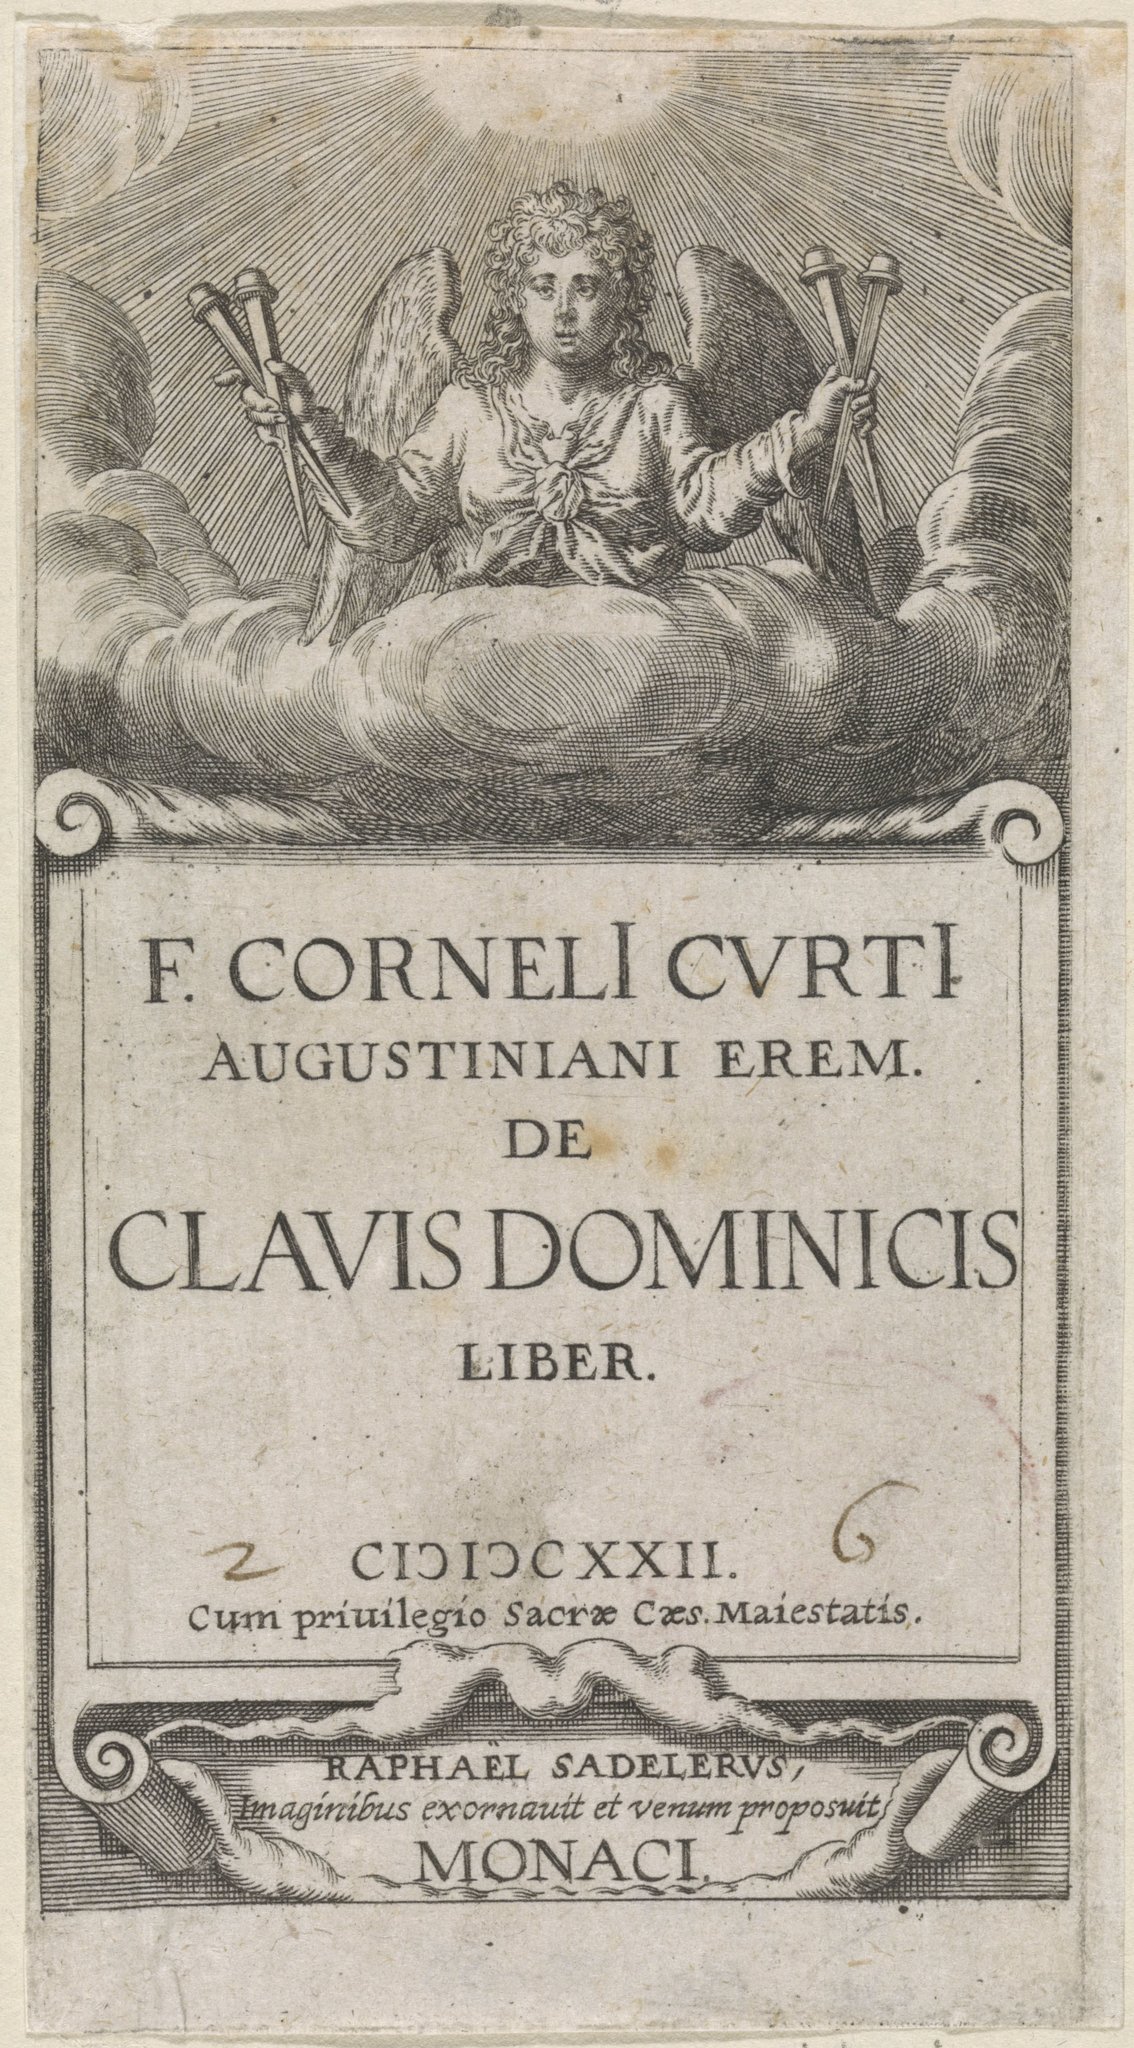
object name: print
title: F. Corneli Curti augustiniani erem. De clavis dominicis liber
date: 1622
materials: paper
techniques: engraving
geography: ingolstadt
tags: nails ~ instruments of the passion (+ angel(s))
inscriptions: collector's mark: Lugt 240, number: ‘2....6’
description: Een cartouche met de titel van het boekwerk. Boven de cartouche houdt een engel de spijkers vast waarmee Christus aan het kruis werd genageld.